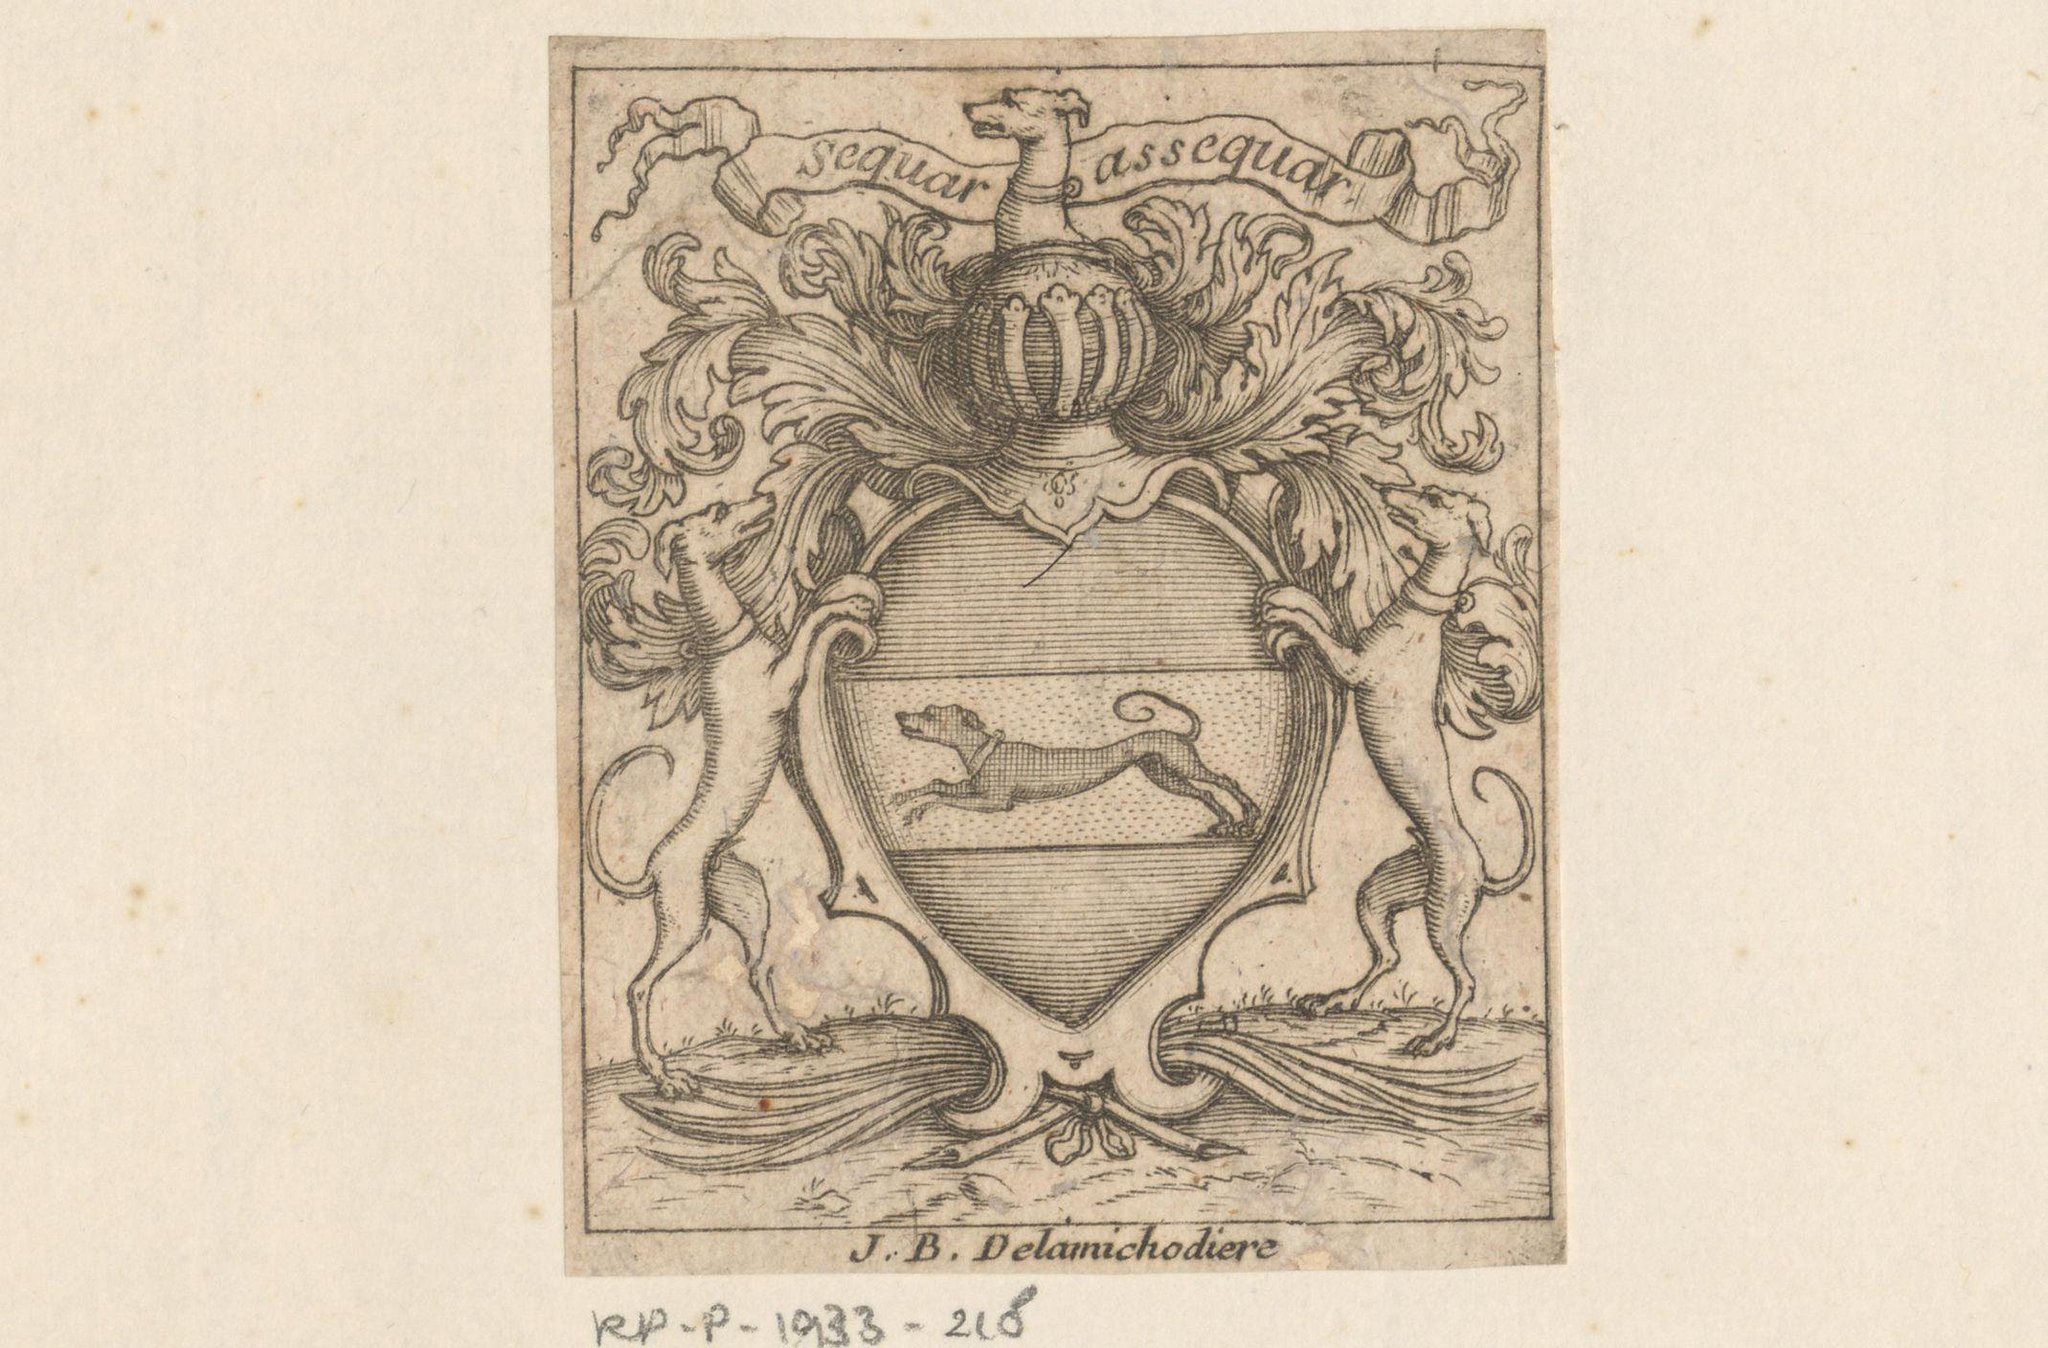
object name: bookplate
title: J.B. Delamichodiere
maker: Anonymous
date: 1730-1797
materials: paper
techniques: engraving, etching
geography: france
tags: armorial bearing, heraldry, dog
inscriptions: collector's mark: Lugt 2760, collector's mark: Lugt 2233